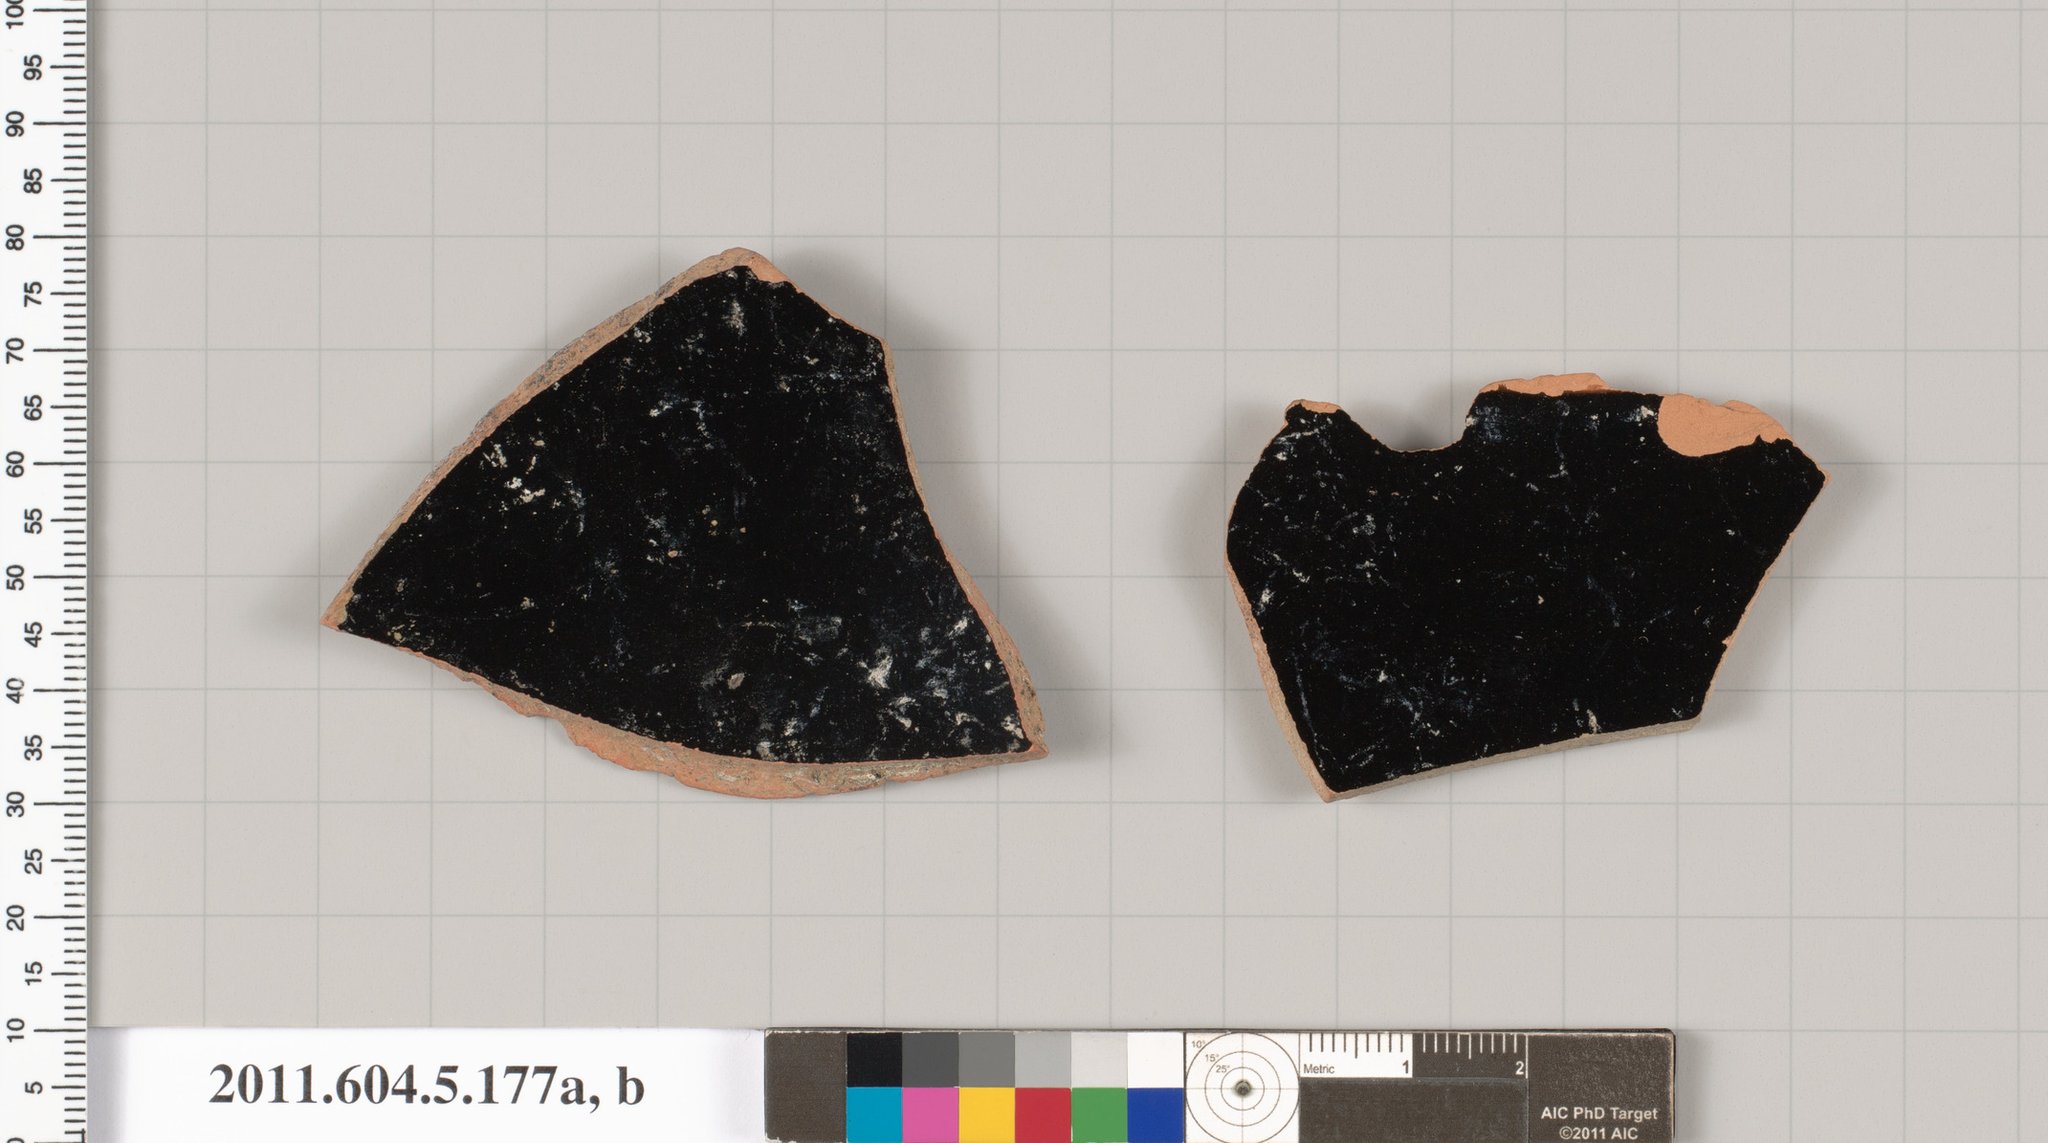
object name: kylix fragment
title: Terracotta fragments of kylikes (drinking cups)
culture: greek, attic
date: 600-401 BCE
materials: terracotta